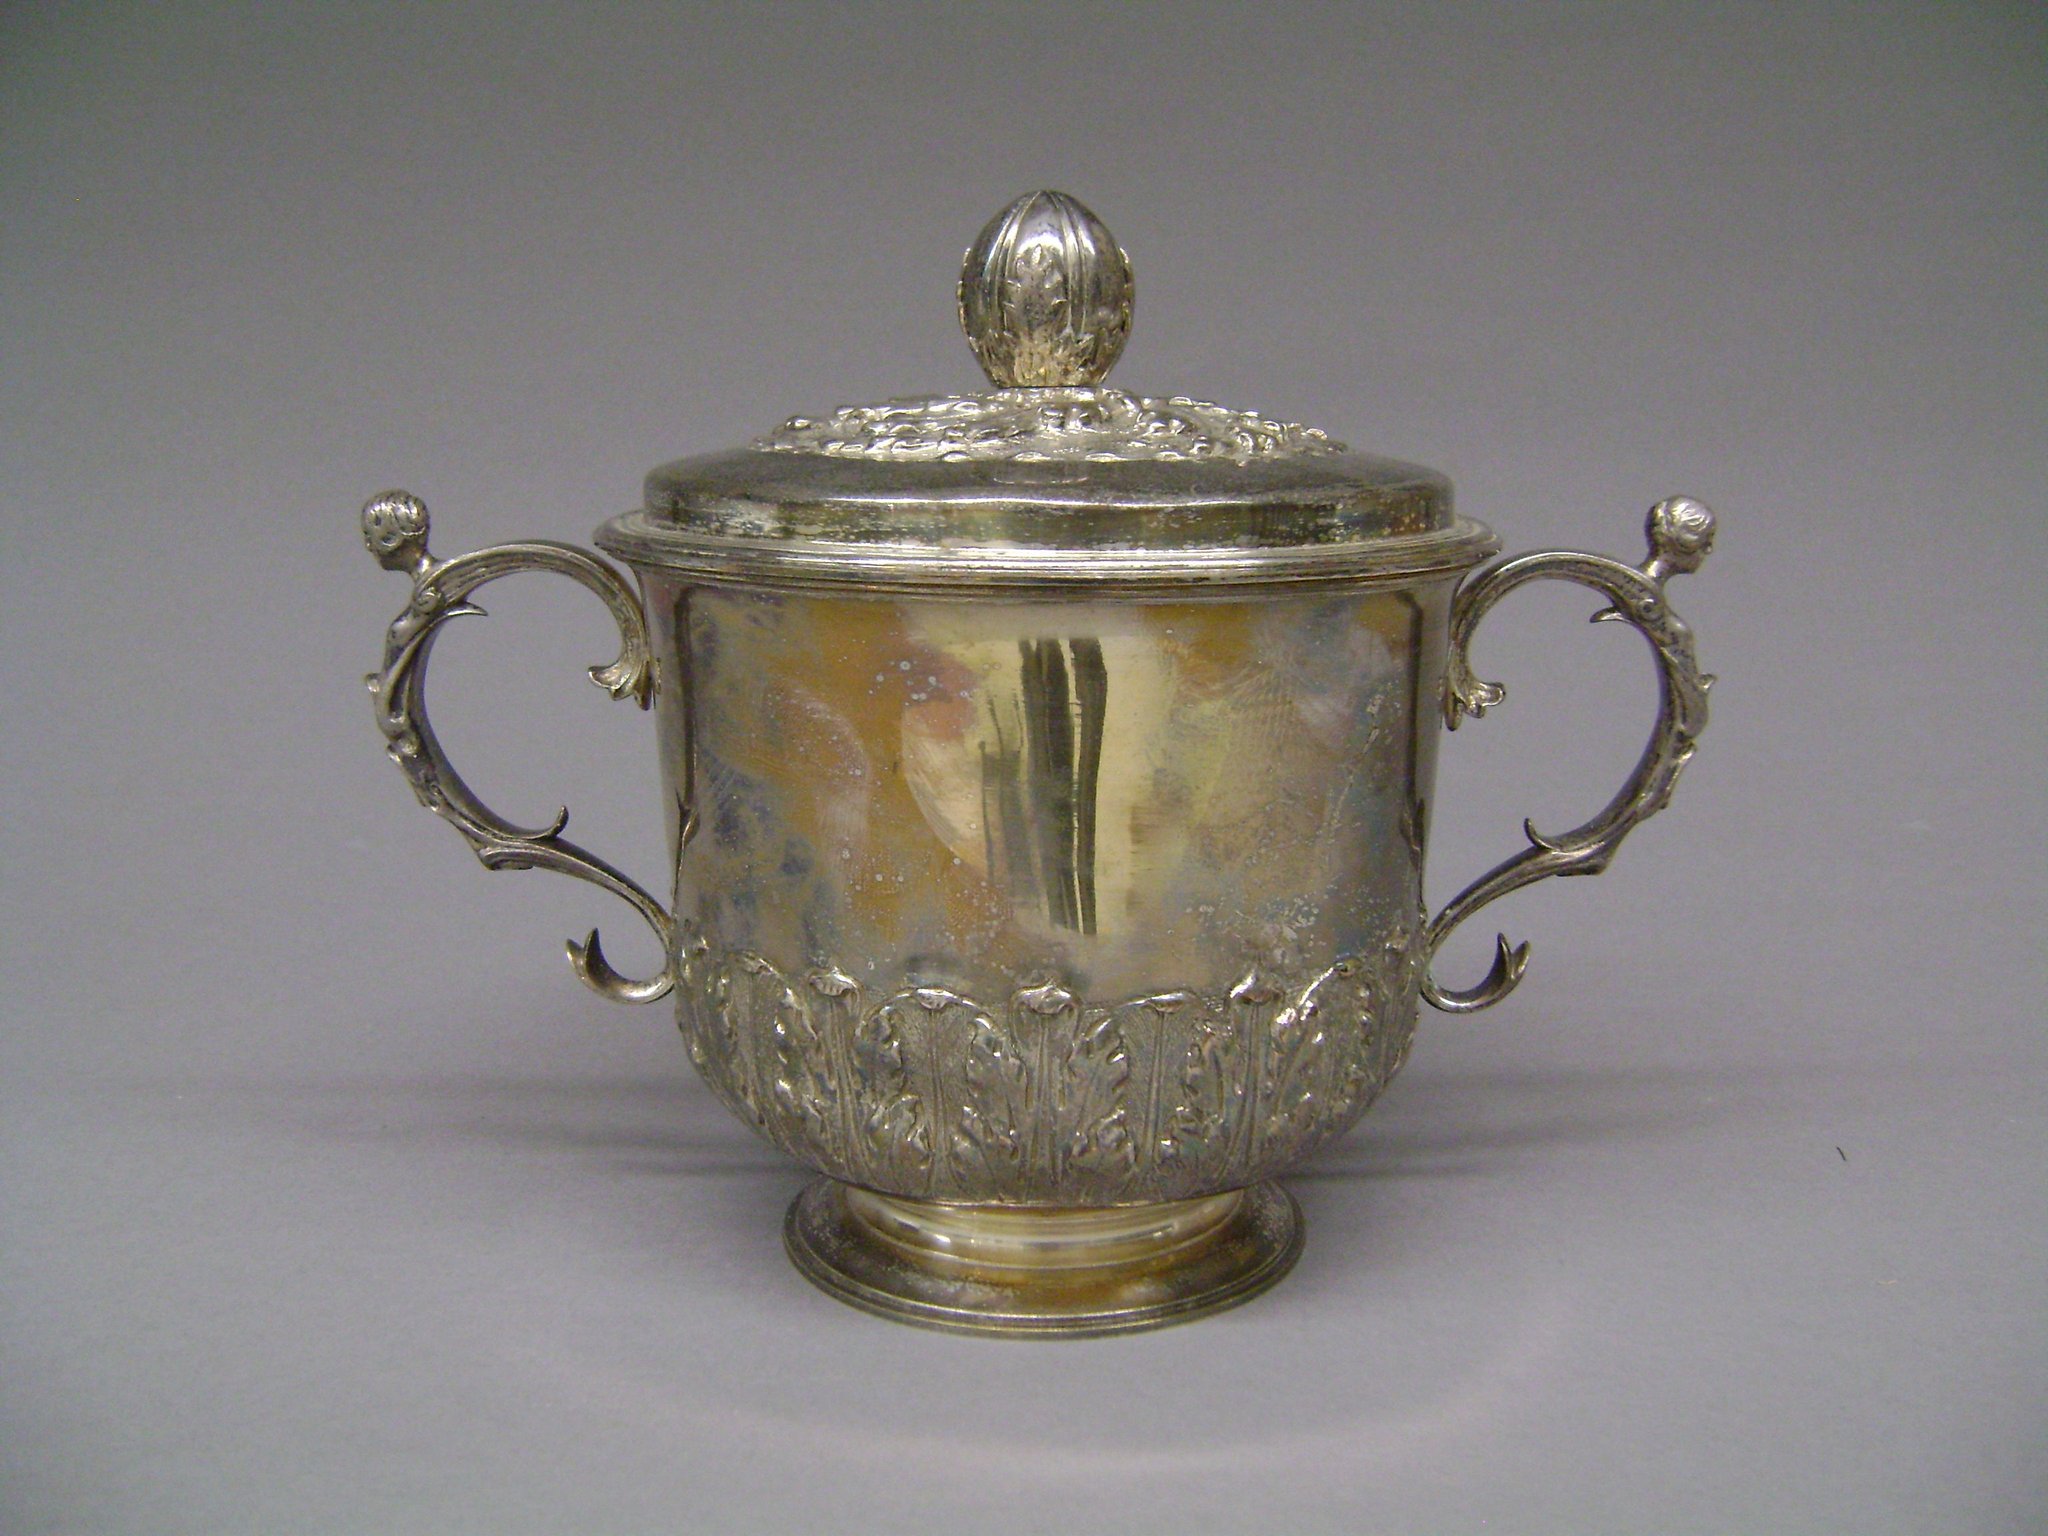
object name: cup with cover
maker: franchi and son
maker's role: manufacturer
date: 1801-1900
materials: metal, silver